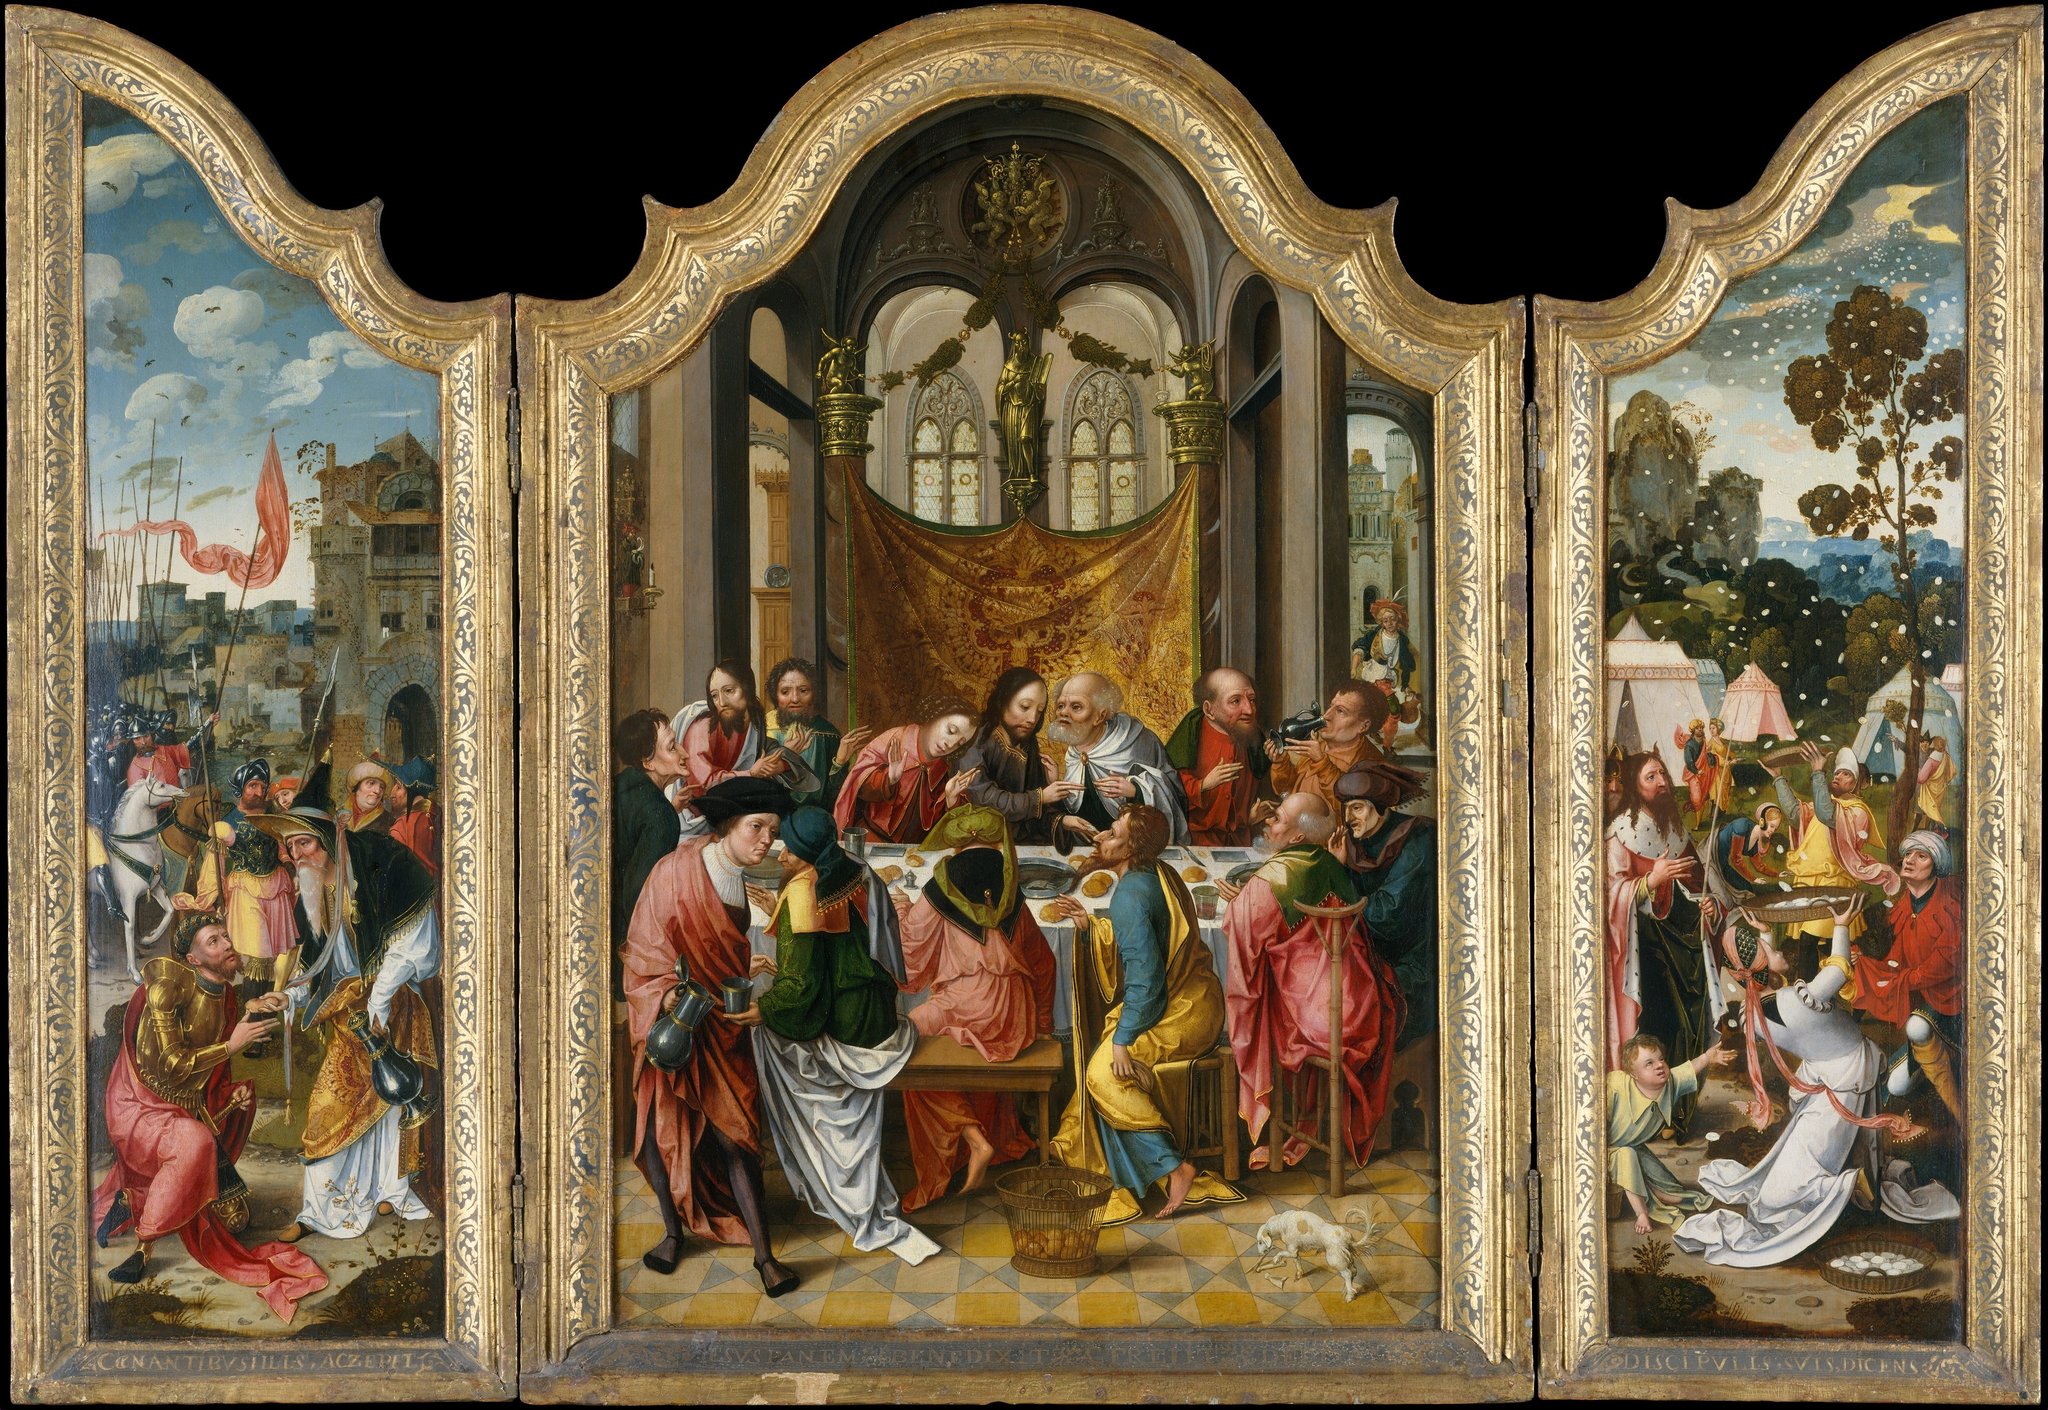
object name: painting, triptych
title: The Last Supper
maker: netherlandish (antwerp mannerist) painters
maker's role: artist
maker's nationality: netherlandish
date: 1515-1520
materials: oil, wood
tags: tents,dogs,apostles,christ,last supper,dining